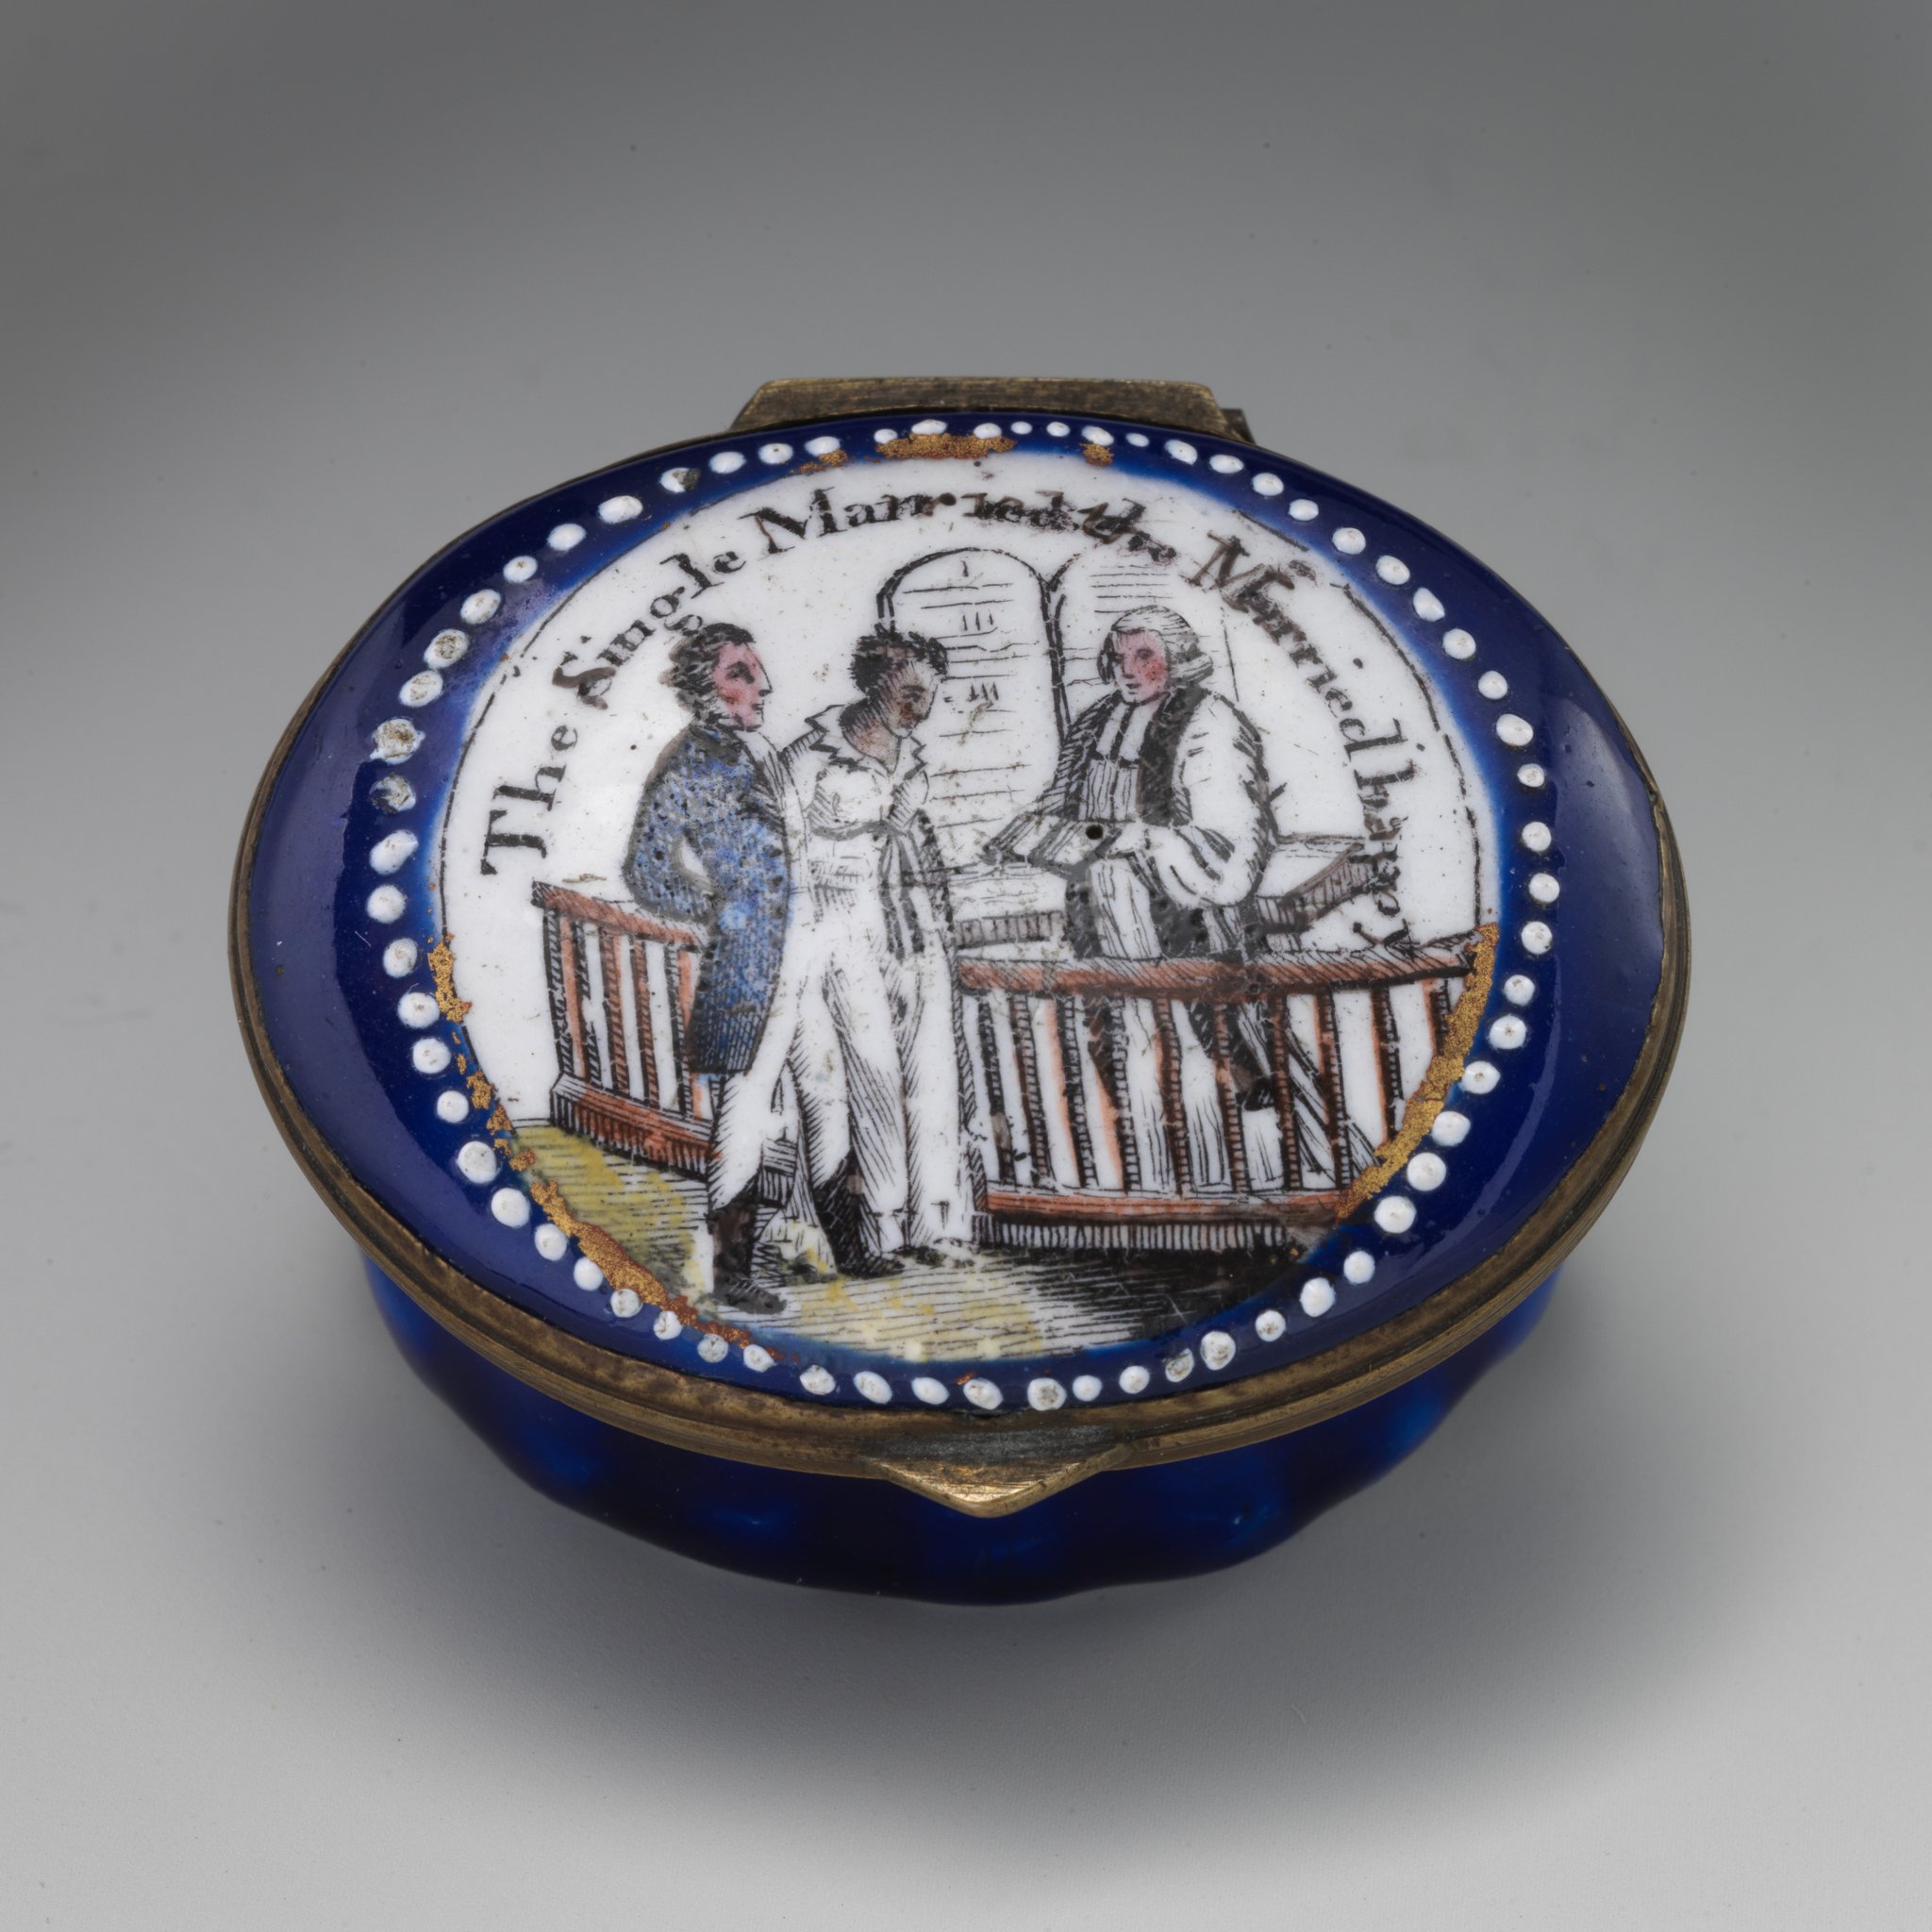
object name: patch box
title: Patch box “The Single Married, the Married Happy”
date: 1820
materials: copper, enamel, glass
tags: men,women